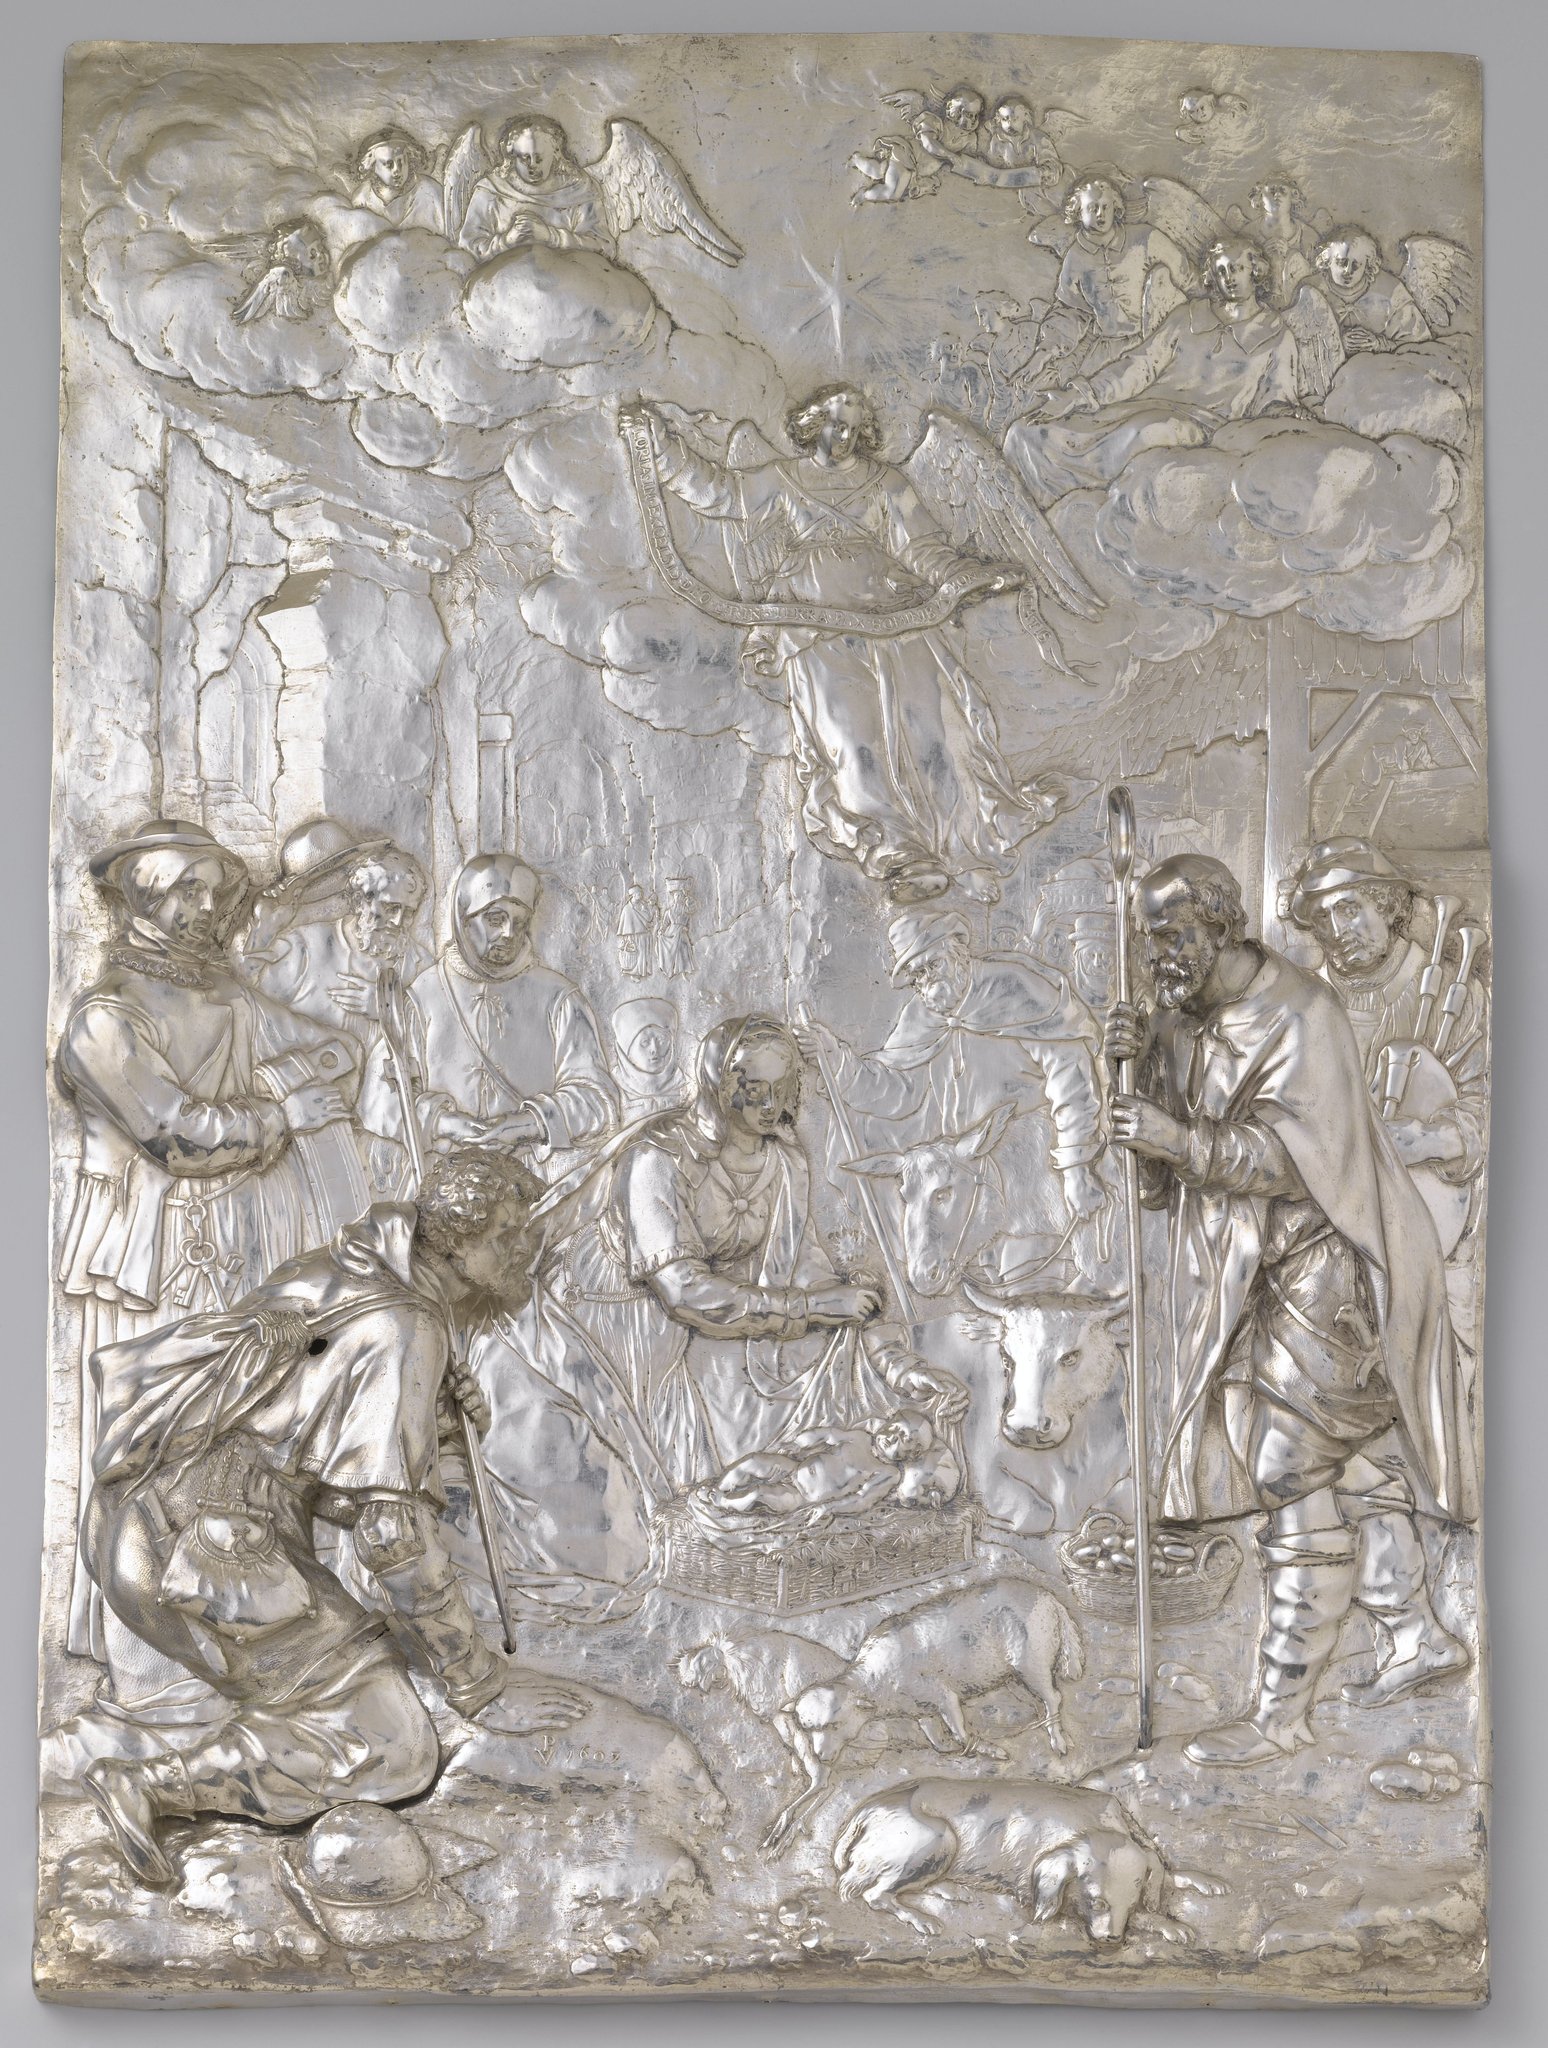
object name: plaque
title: The Adoration of the Shepherds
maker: paulus willemsz. van vianen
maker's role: draughtsman, jeweler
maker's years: 1570-1614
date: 1607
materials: silver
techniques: repoussé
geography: prague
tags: adoration of the christ-child by the shepherds; mary and joseph present (+ angel(s) floating in the air)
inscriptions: signature and date, inscription: ‘GLORIA . IN . EXCELSIS . DEO . ET. IN . TERRA . PAX . HOMINIBVS . BONAE . V[OLV]NTATIS’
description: Een rechthoekige plaquette van zilver met de voorstelling van de aanbidding der herders. In het midden is Maria weergegeven, neergeknield bij een mand waarin het naakte Christuskind ligt. Aan de onderzijde van de plaquette is een omgebogen rand met drie kleine gaten.